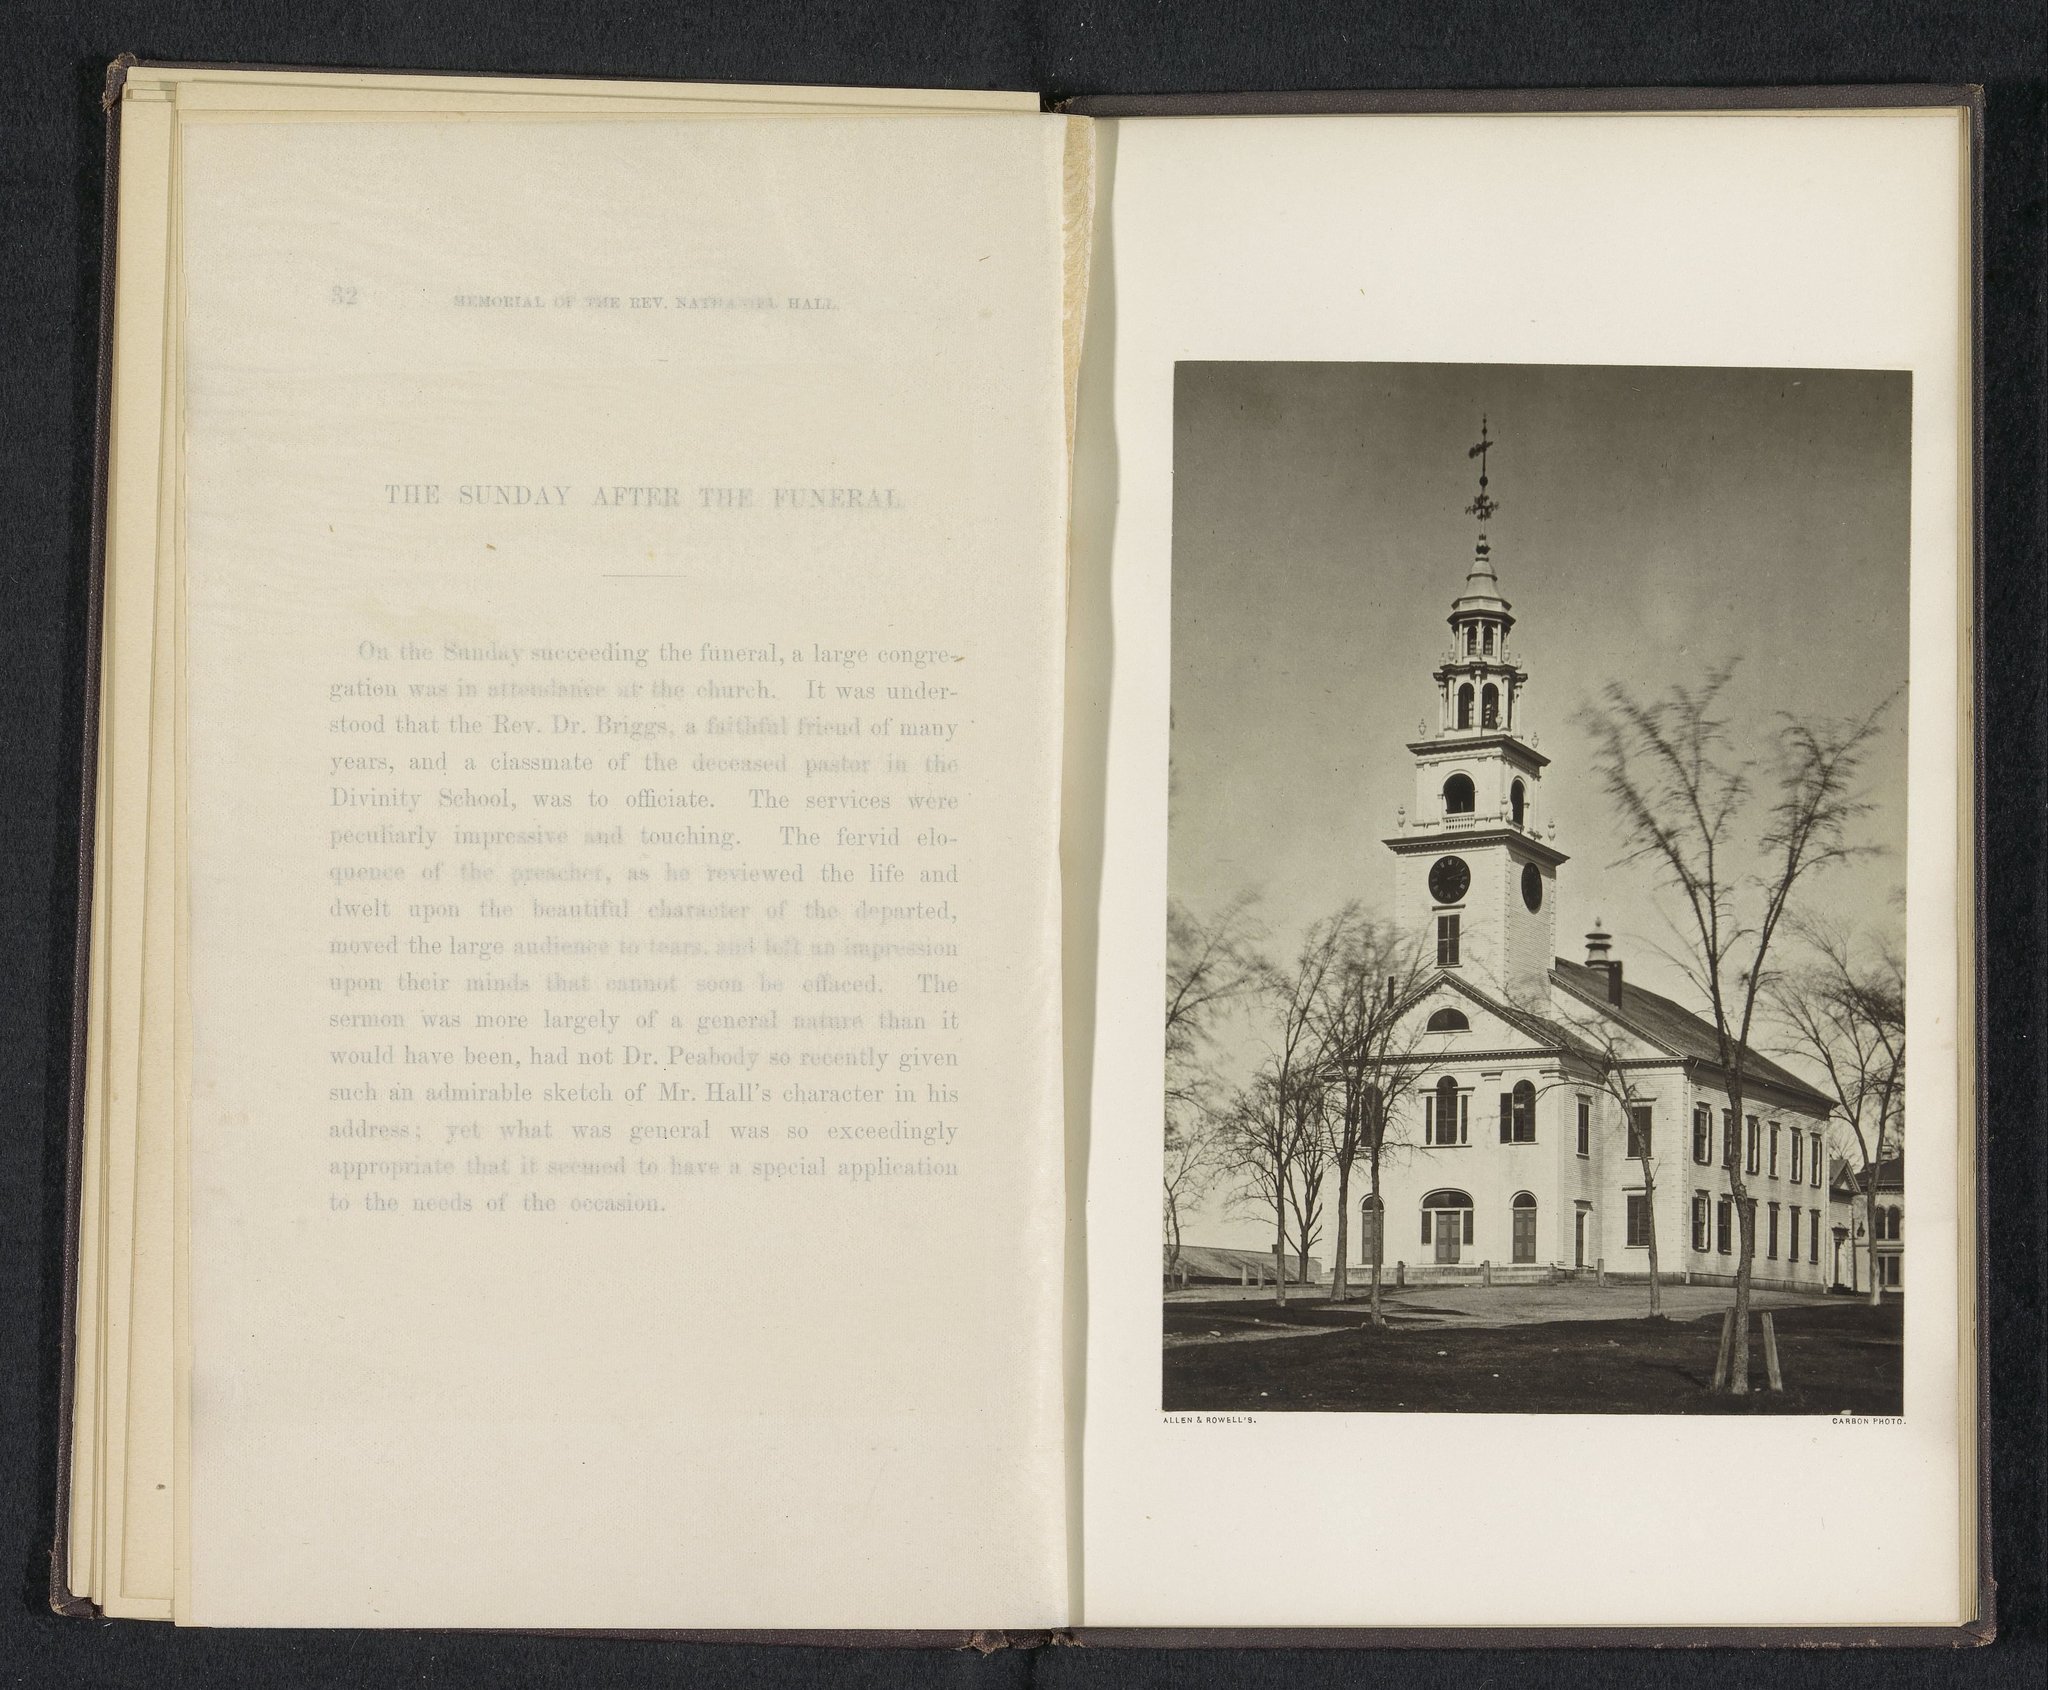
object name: page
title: Exterieur van de First Parish Church te Dorchester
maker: Anonymous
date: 1871-1876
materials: paper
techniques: woodburytype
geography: dorchester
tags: functionaries and dignitaries ~ protestant churches